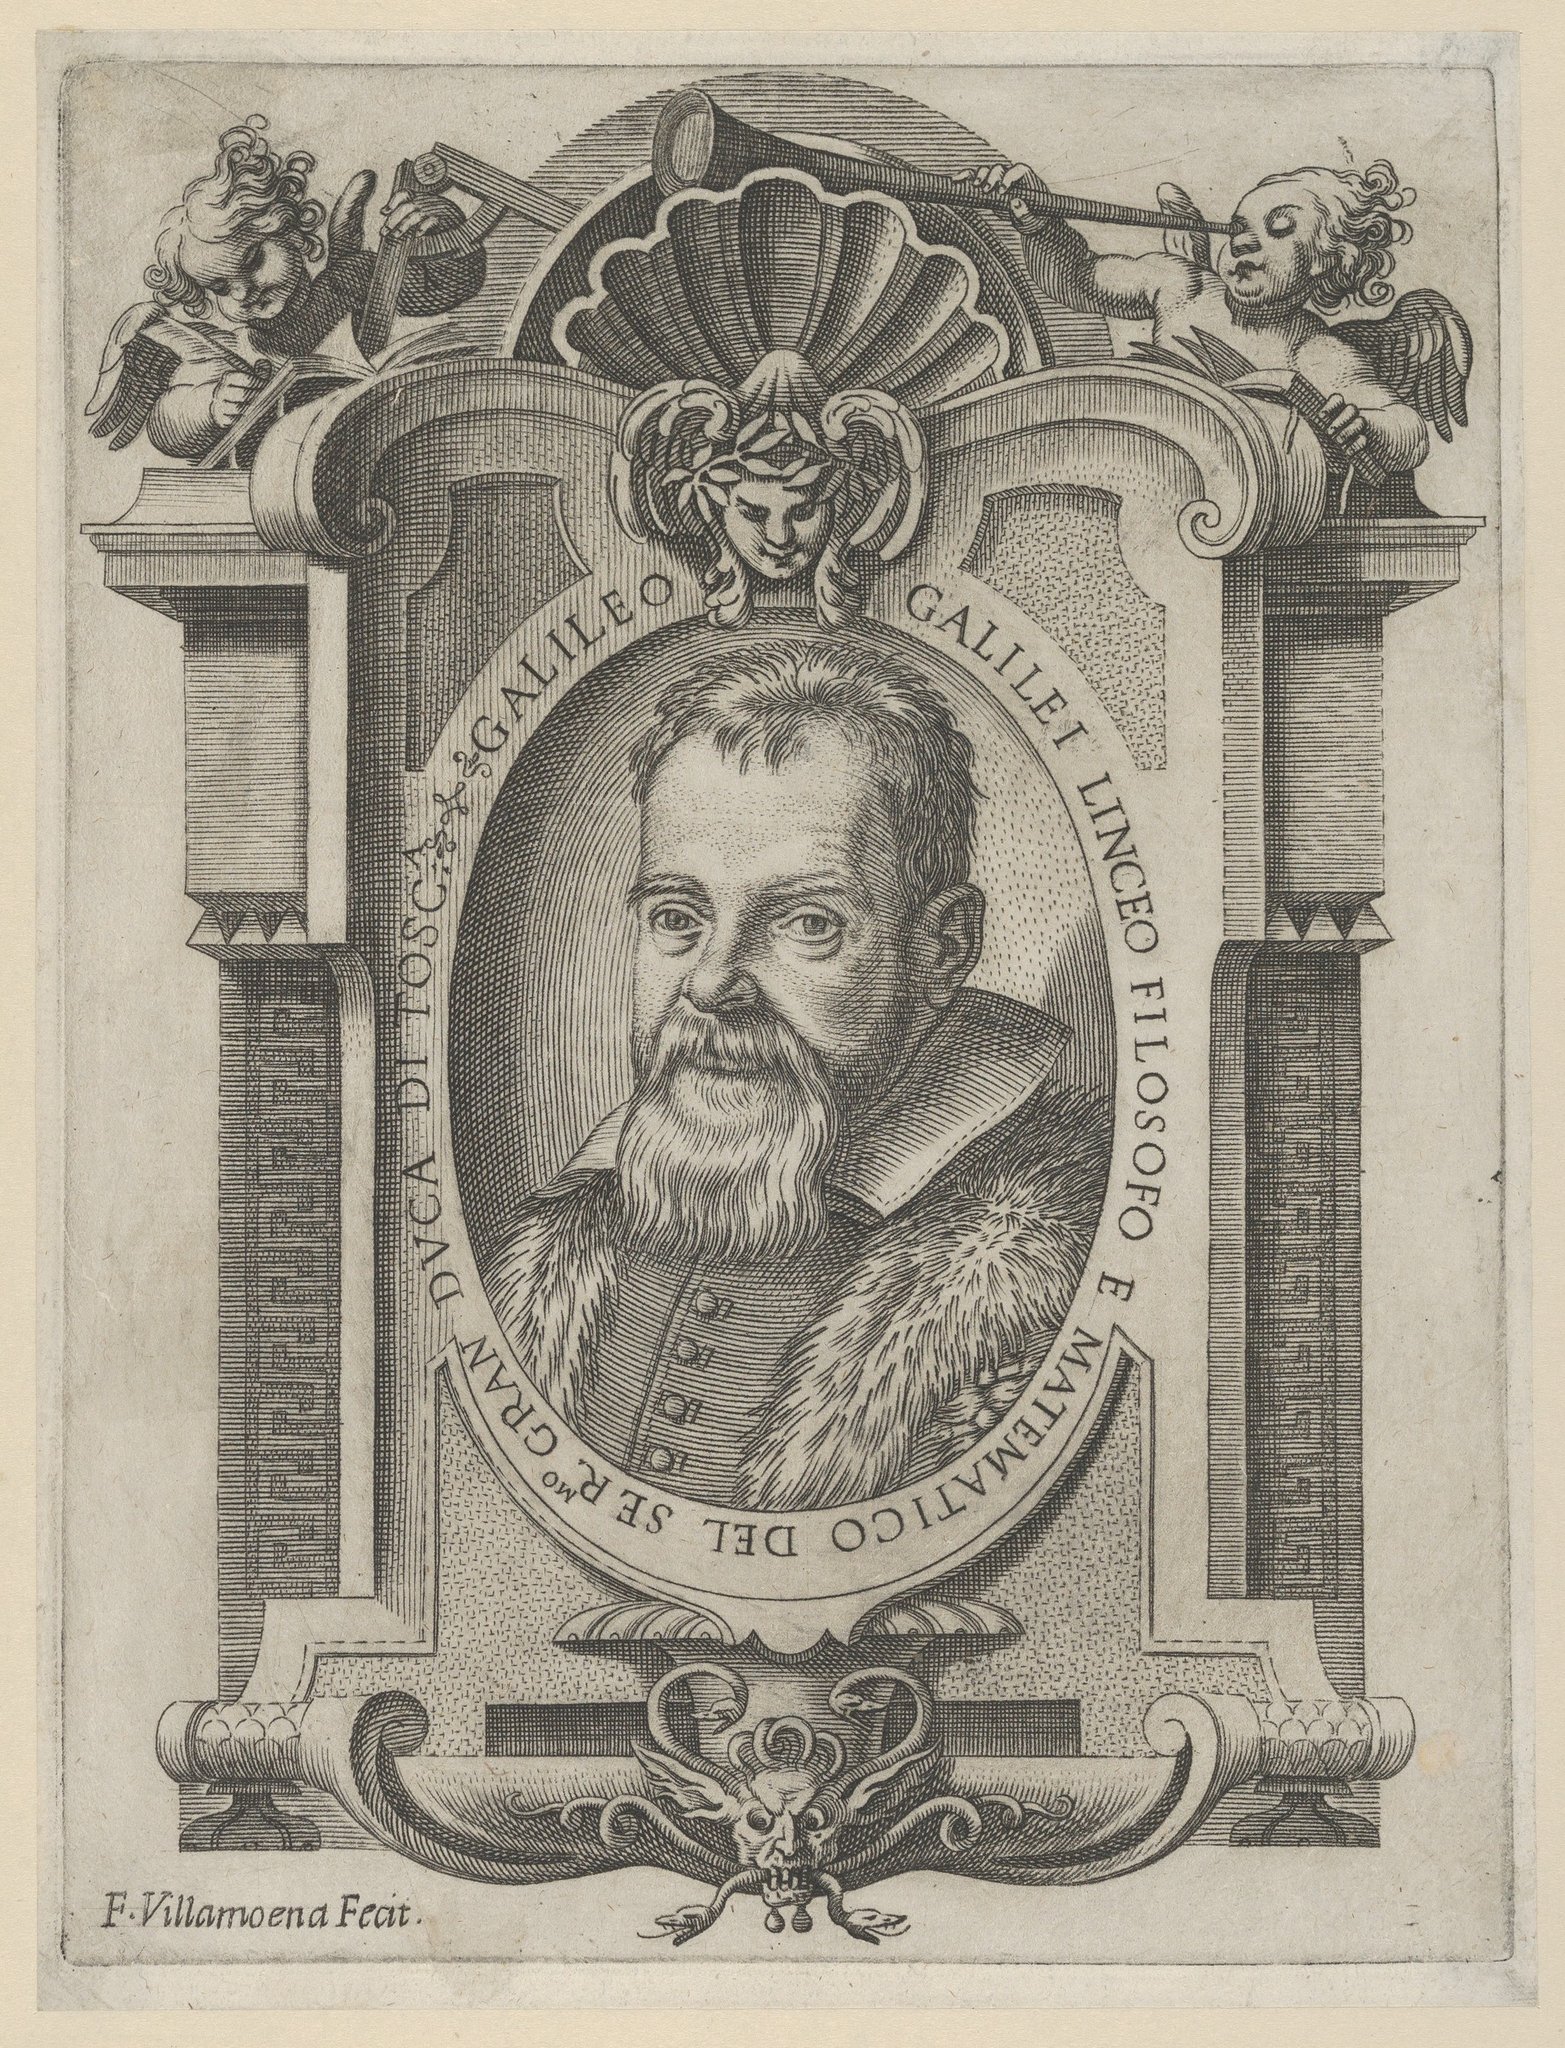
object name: print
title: Portrait of Galileo Galilei set within an elaborate cartouche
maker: francesco villamena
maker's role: artist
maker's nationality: italian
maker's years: 1565-1624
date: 1623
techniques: engraving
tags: men,portraits